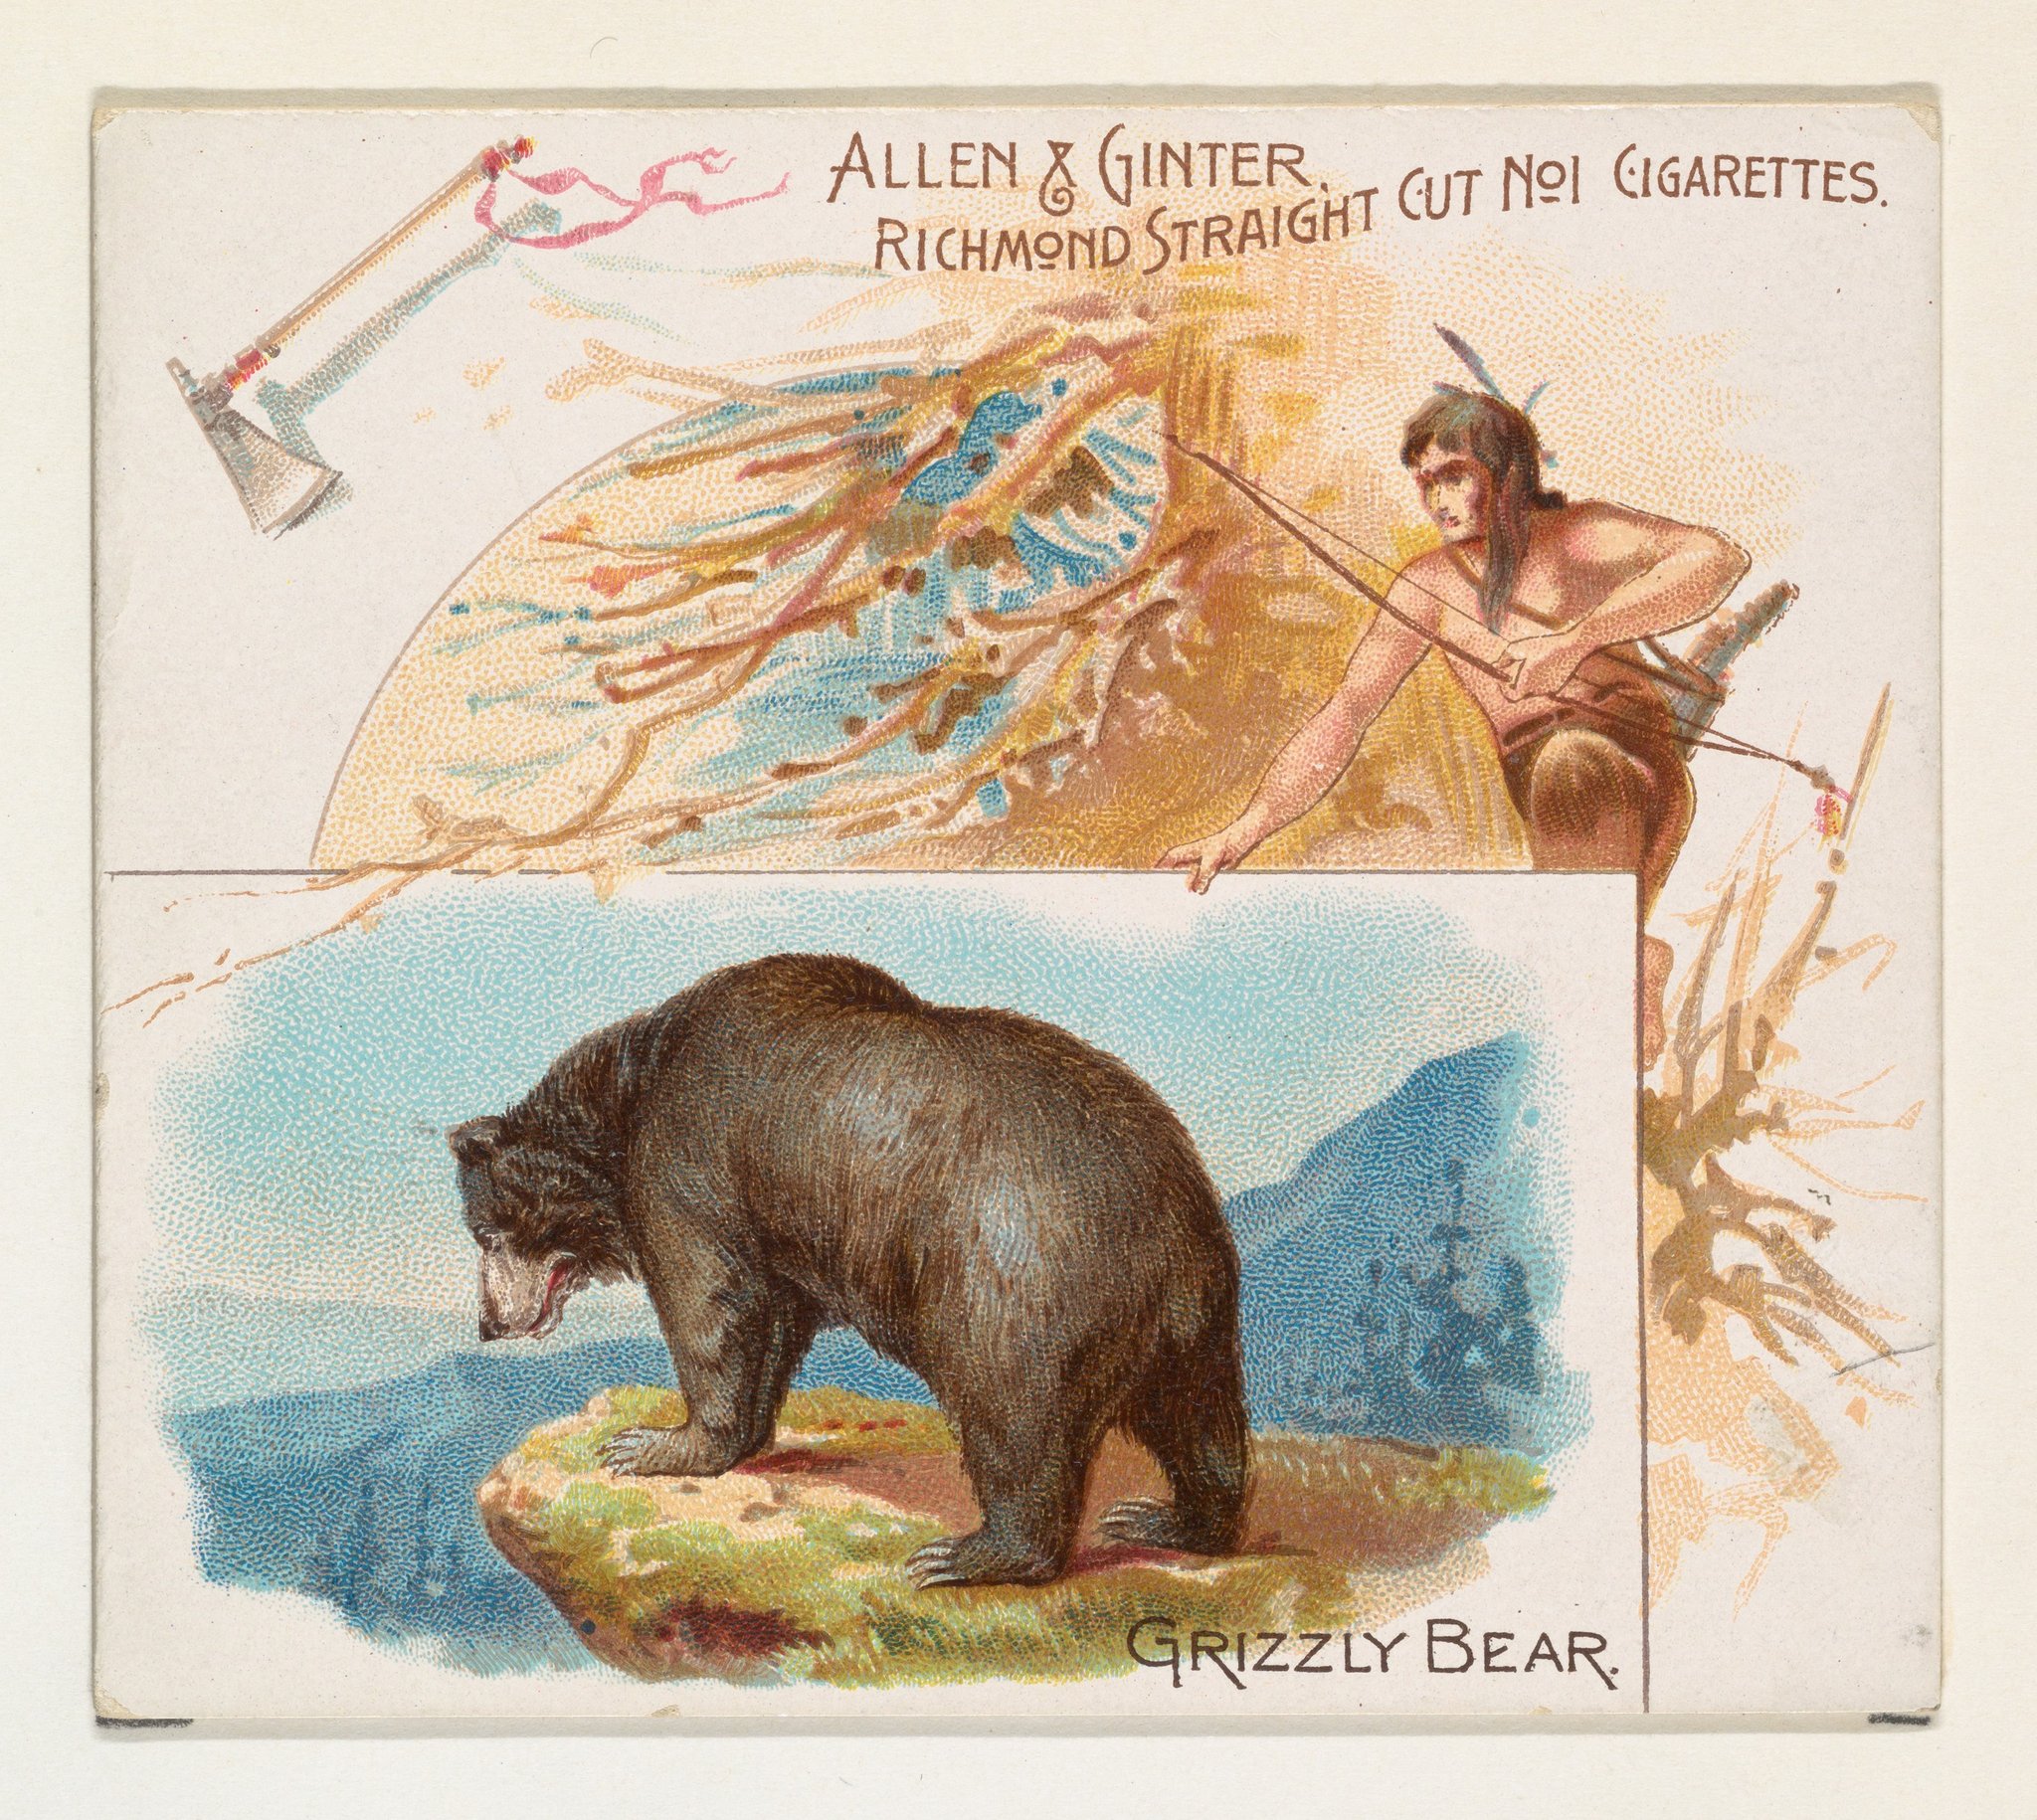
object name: print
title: Grizzly Bear, from Quadrupeds series (N41) for Allen & Ginter Cigarettes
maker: allen & ginter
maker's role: publisher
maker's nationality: american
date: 1890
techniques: color lithograph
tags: bears